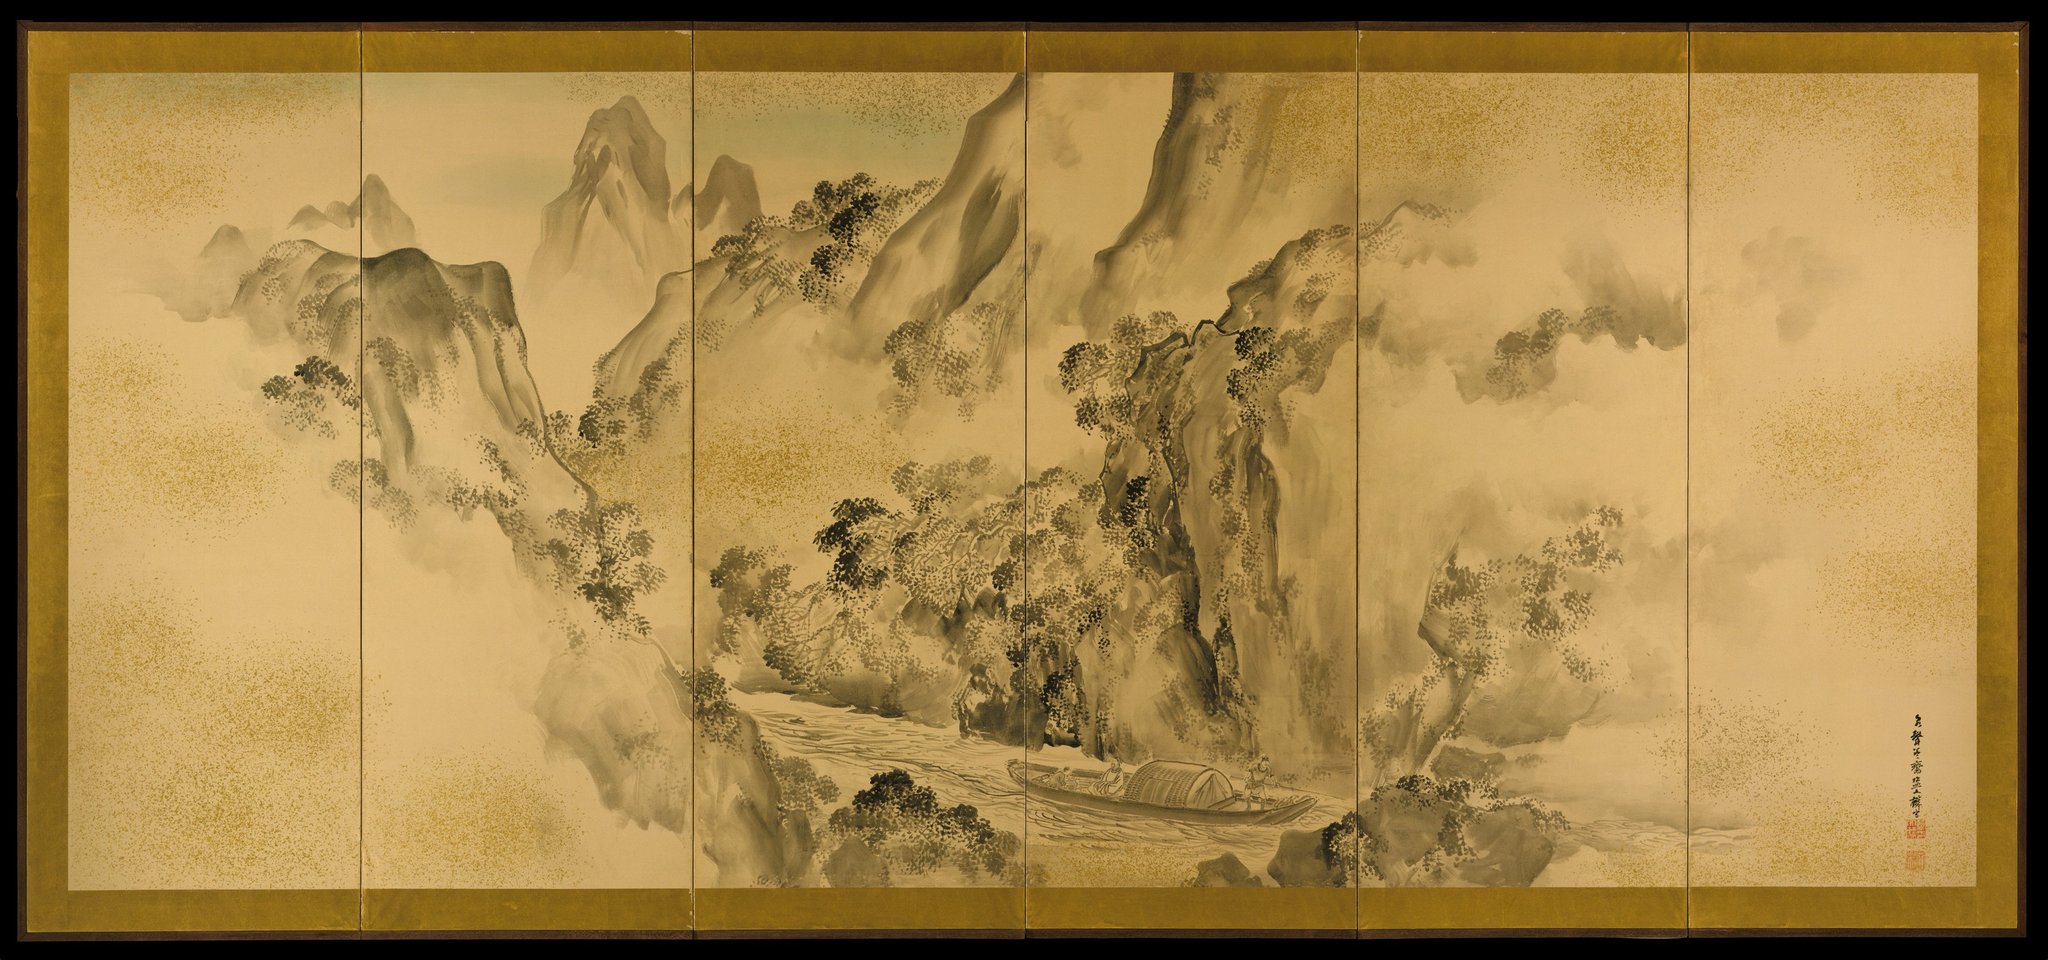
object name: screen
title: The Poet Li Bo's Visit to Mount Emei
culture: japanese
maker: shiokawa bunrin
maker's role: artist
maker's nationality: japanese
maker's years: 1808-1877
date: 1875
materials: gold, ink, panel, paper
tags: men,rivers,mountains,night,boats